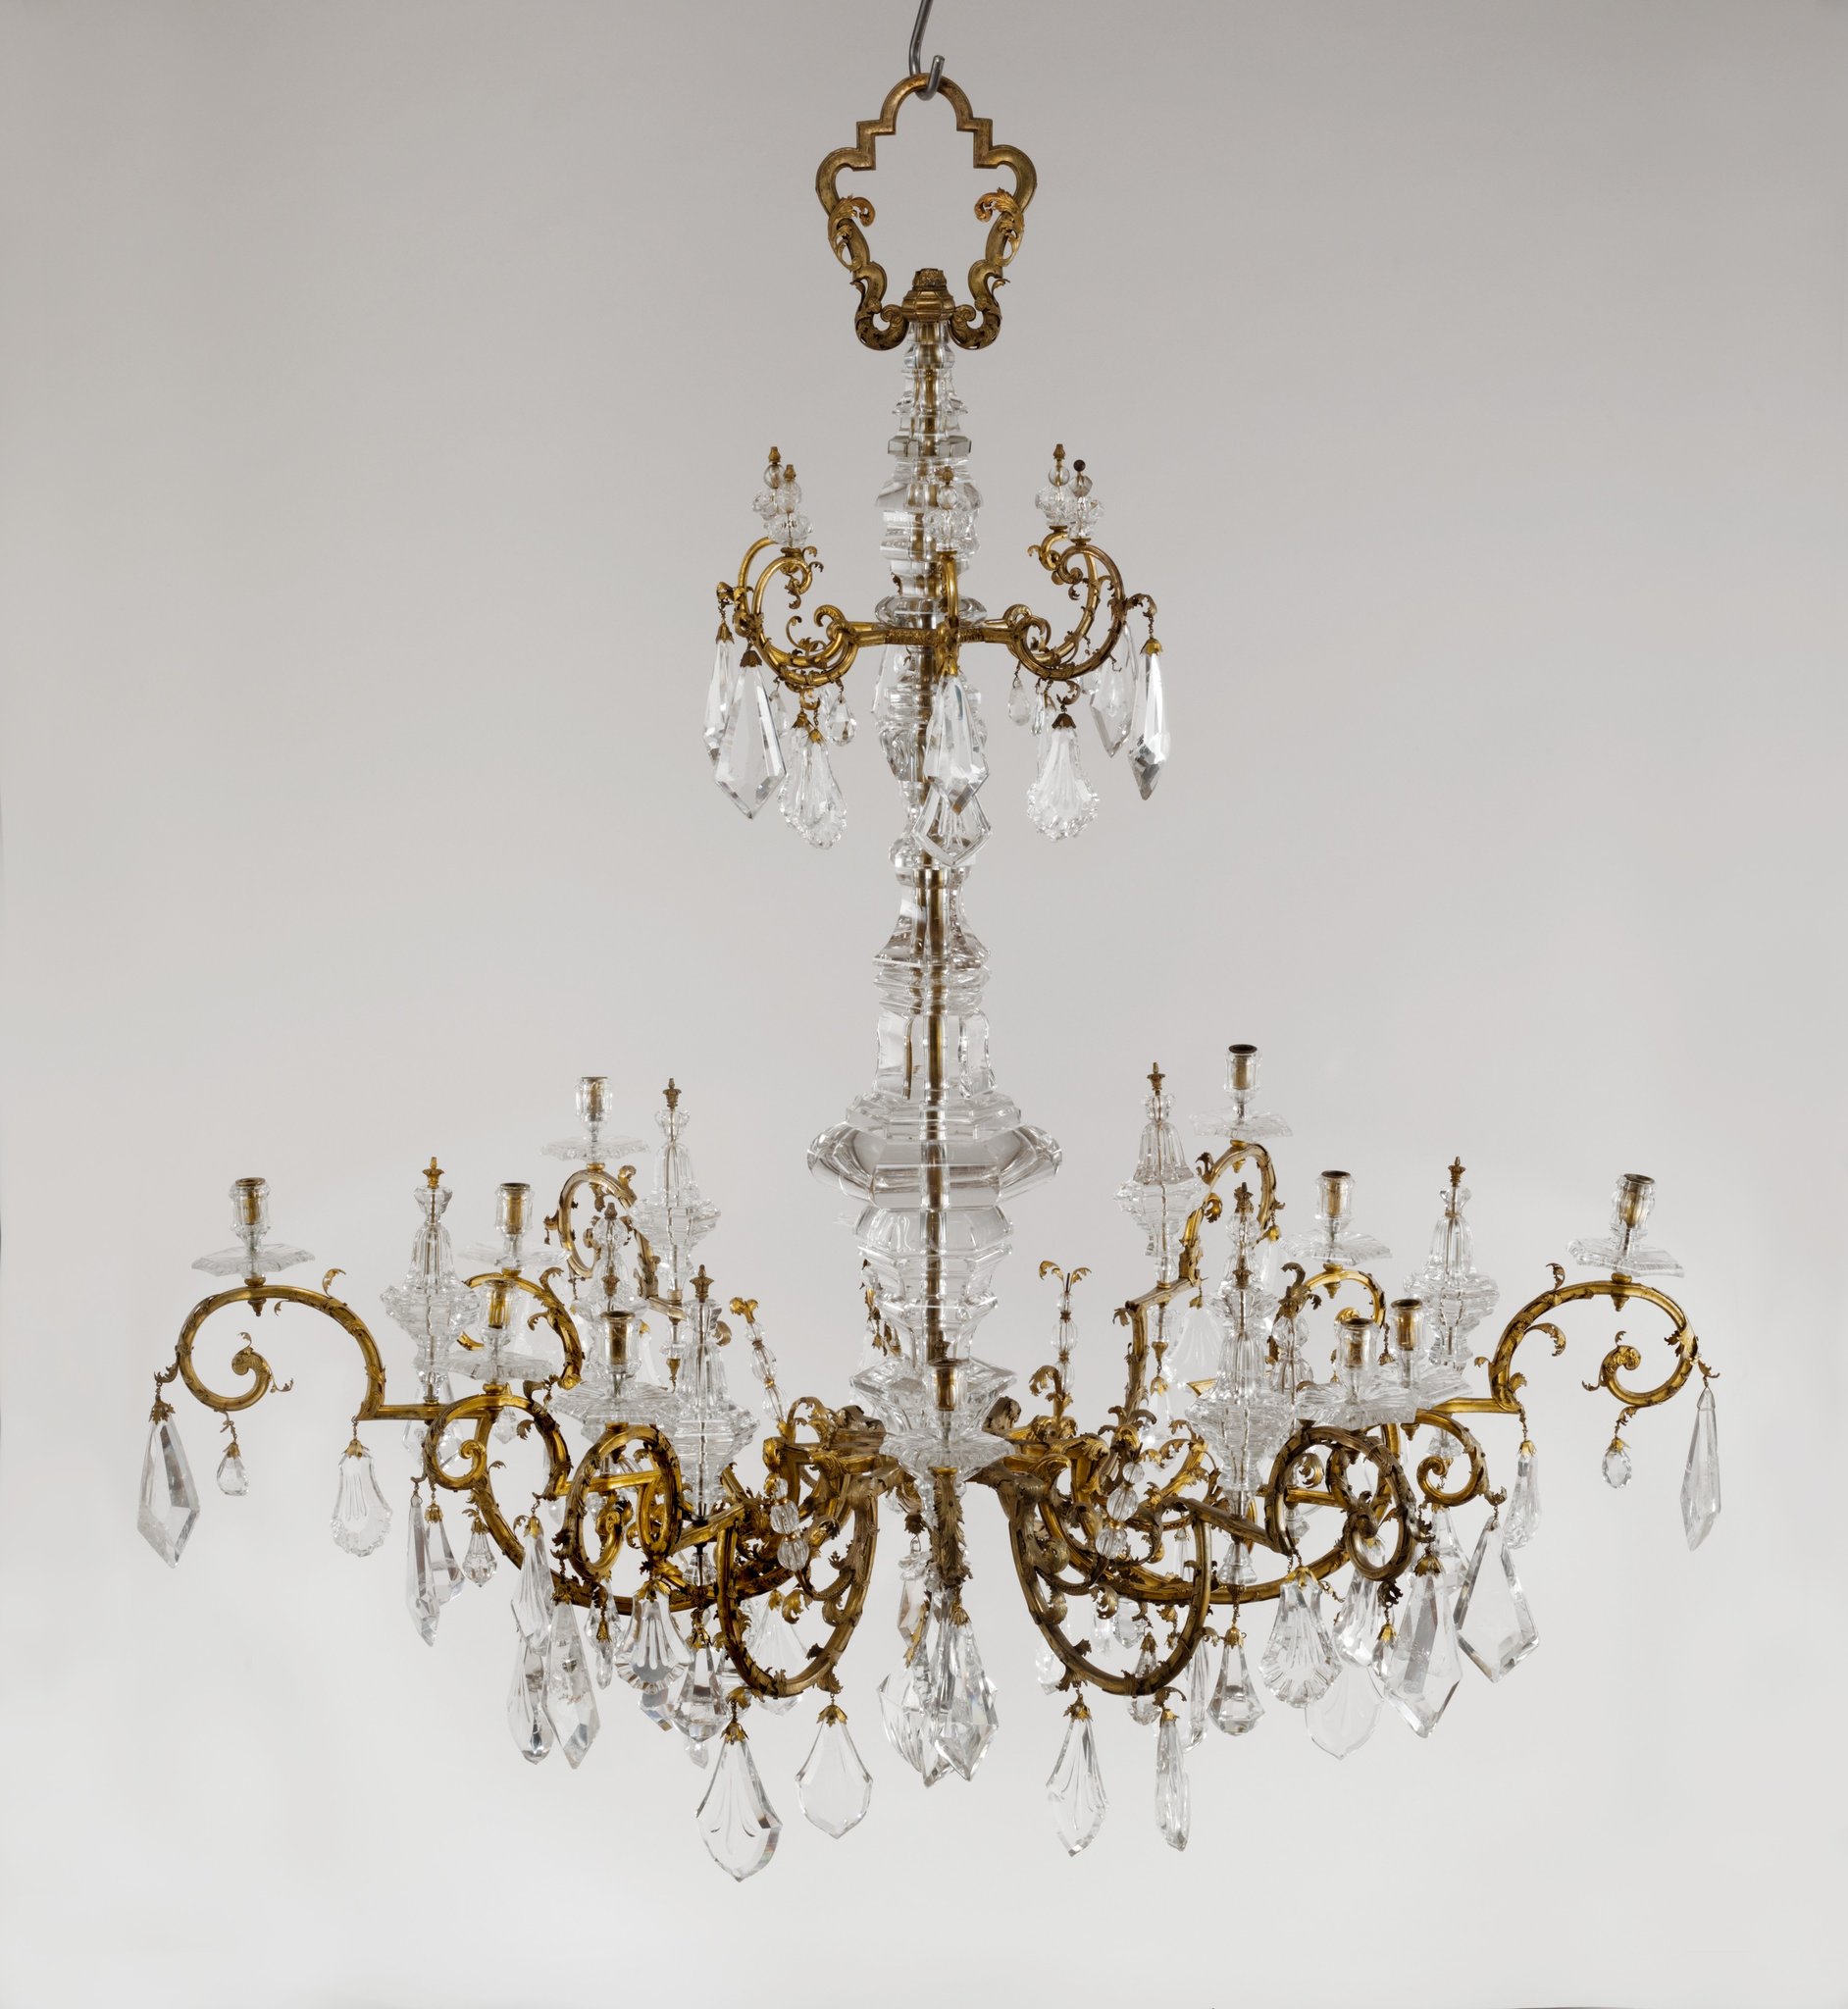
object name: chandelier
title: Twelve-light chandelier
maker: giovanni battista metellino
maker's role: maker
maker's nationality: italian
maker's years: 1624-1724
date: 1701-1725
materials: gilt, quartz, steel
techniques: gilding